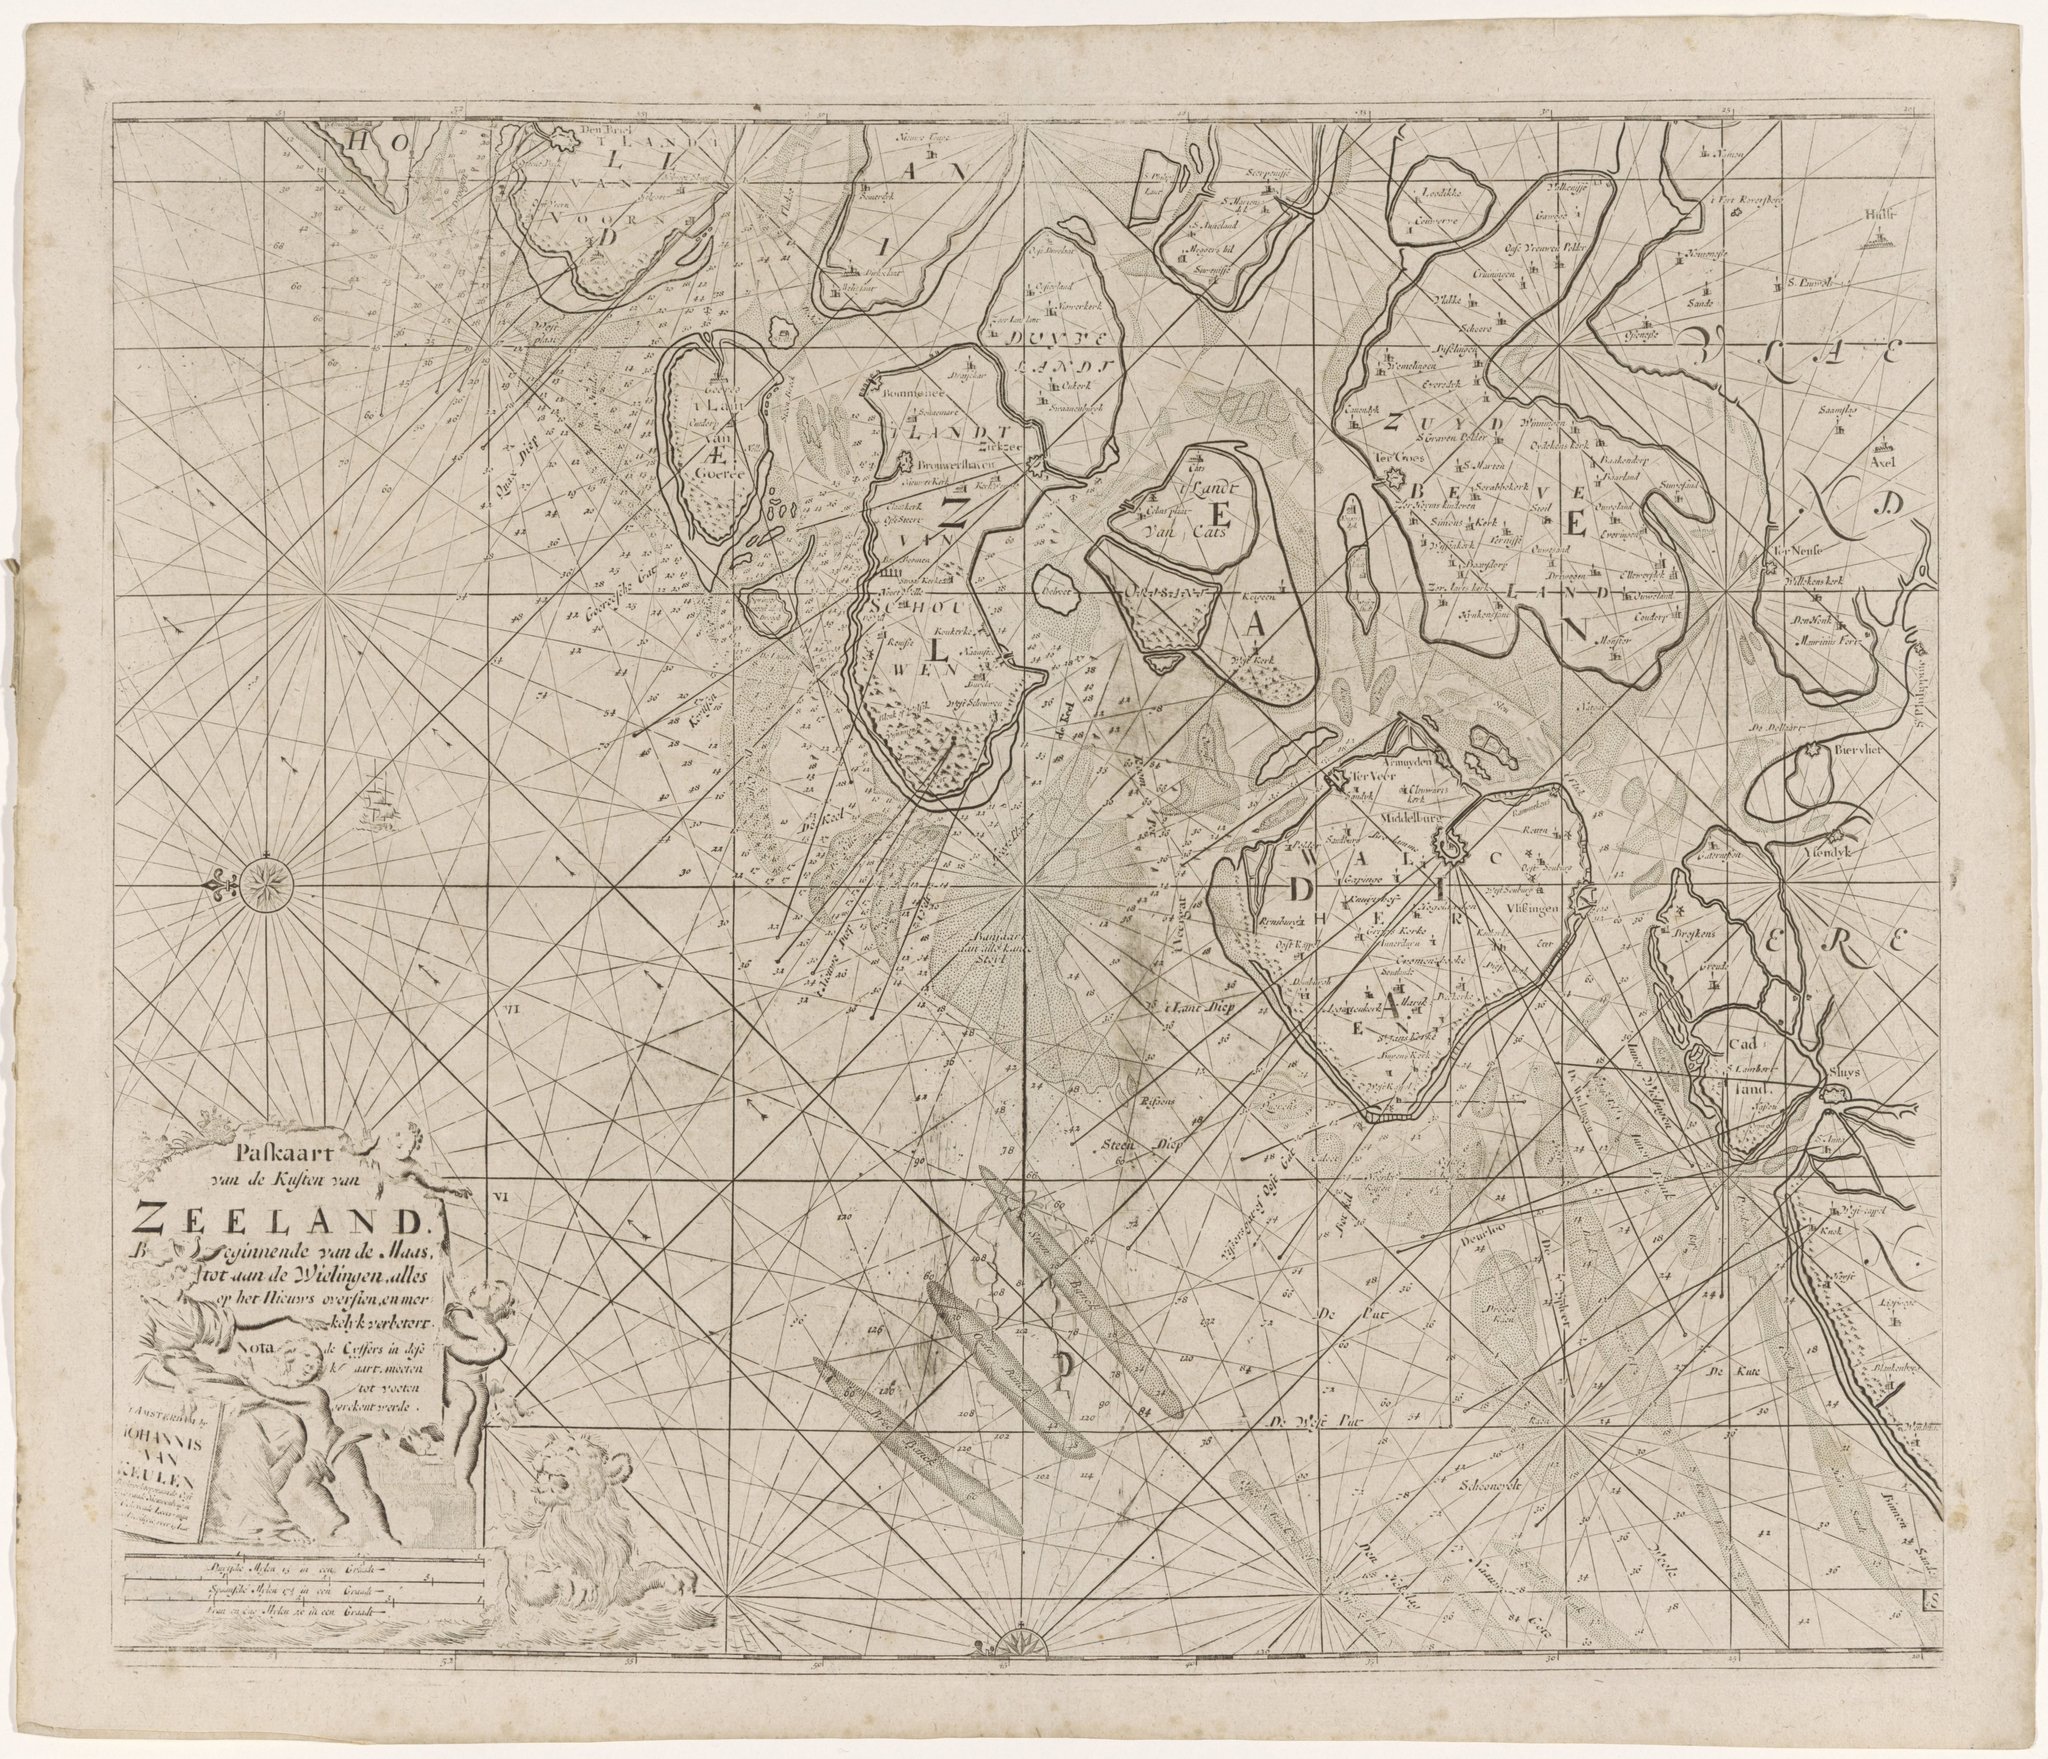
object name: print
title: Paskaart van de Zeeuwse Eilanden en deel van de Noordzee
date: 1681-1803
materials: paper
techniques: engraving, etching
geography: amsterdam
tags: sailing-ship, sailing-boat, beasts of prey, predatory animals: lion, cupids: 'amores', 'amoretti', 'putti', zeeland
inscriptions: collector's mark: Lugt 2228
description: Paskaart van de Zeeuwse Eilanden en deel van de Noordzee, met twee kompasrozen, het Noorden ligt links. Linksonder een cartouche met de titel, het adres van de uitgever en de schaalverdeling, weergegeven in Duitse, Spaanse en Engelse of Franse mijlen (schaal: c. 1:170.000). Bij deze gegevens enkele putti, een vrouw met een schepenkroon en een leeuw.